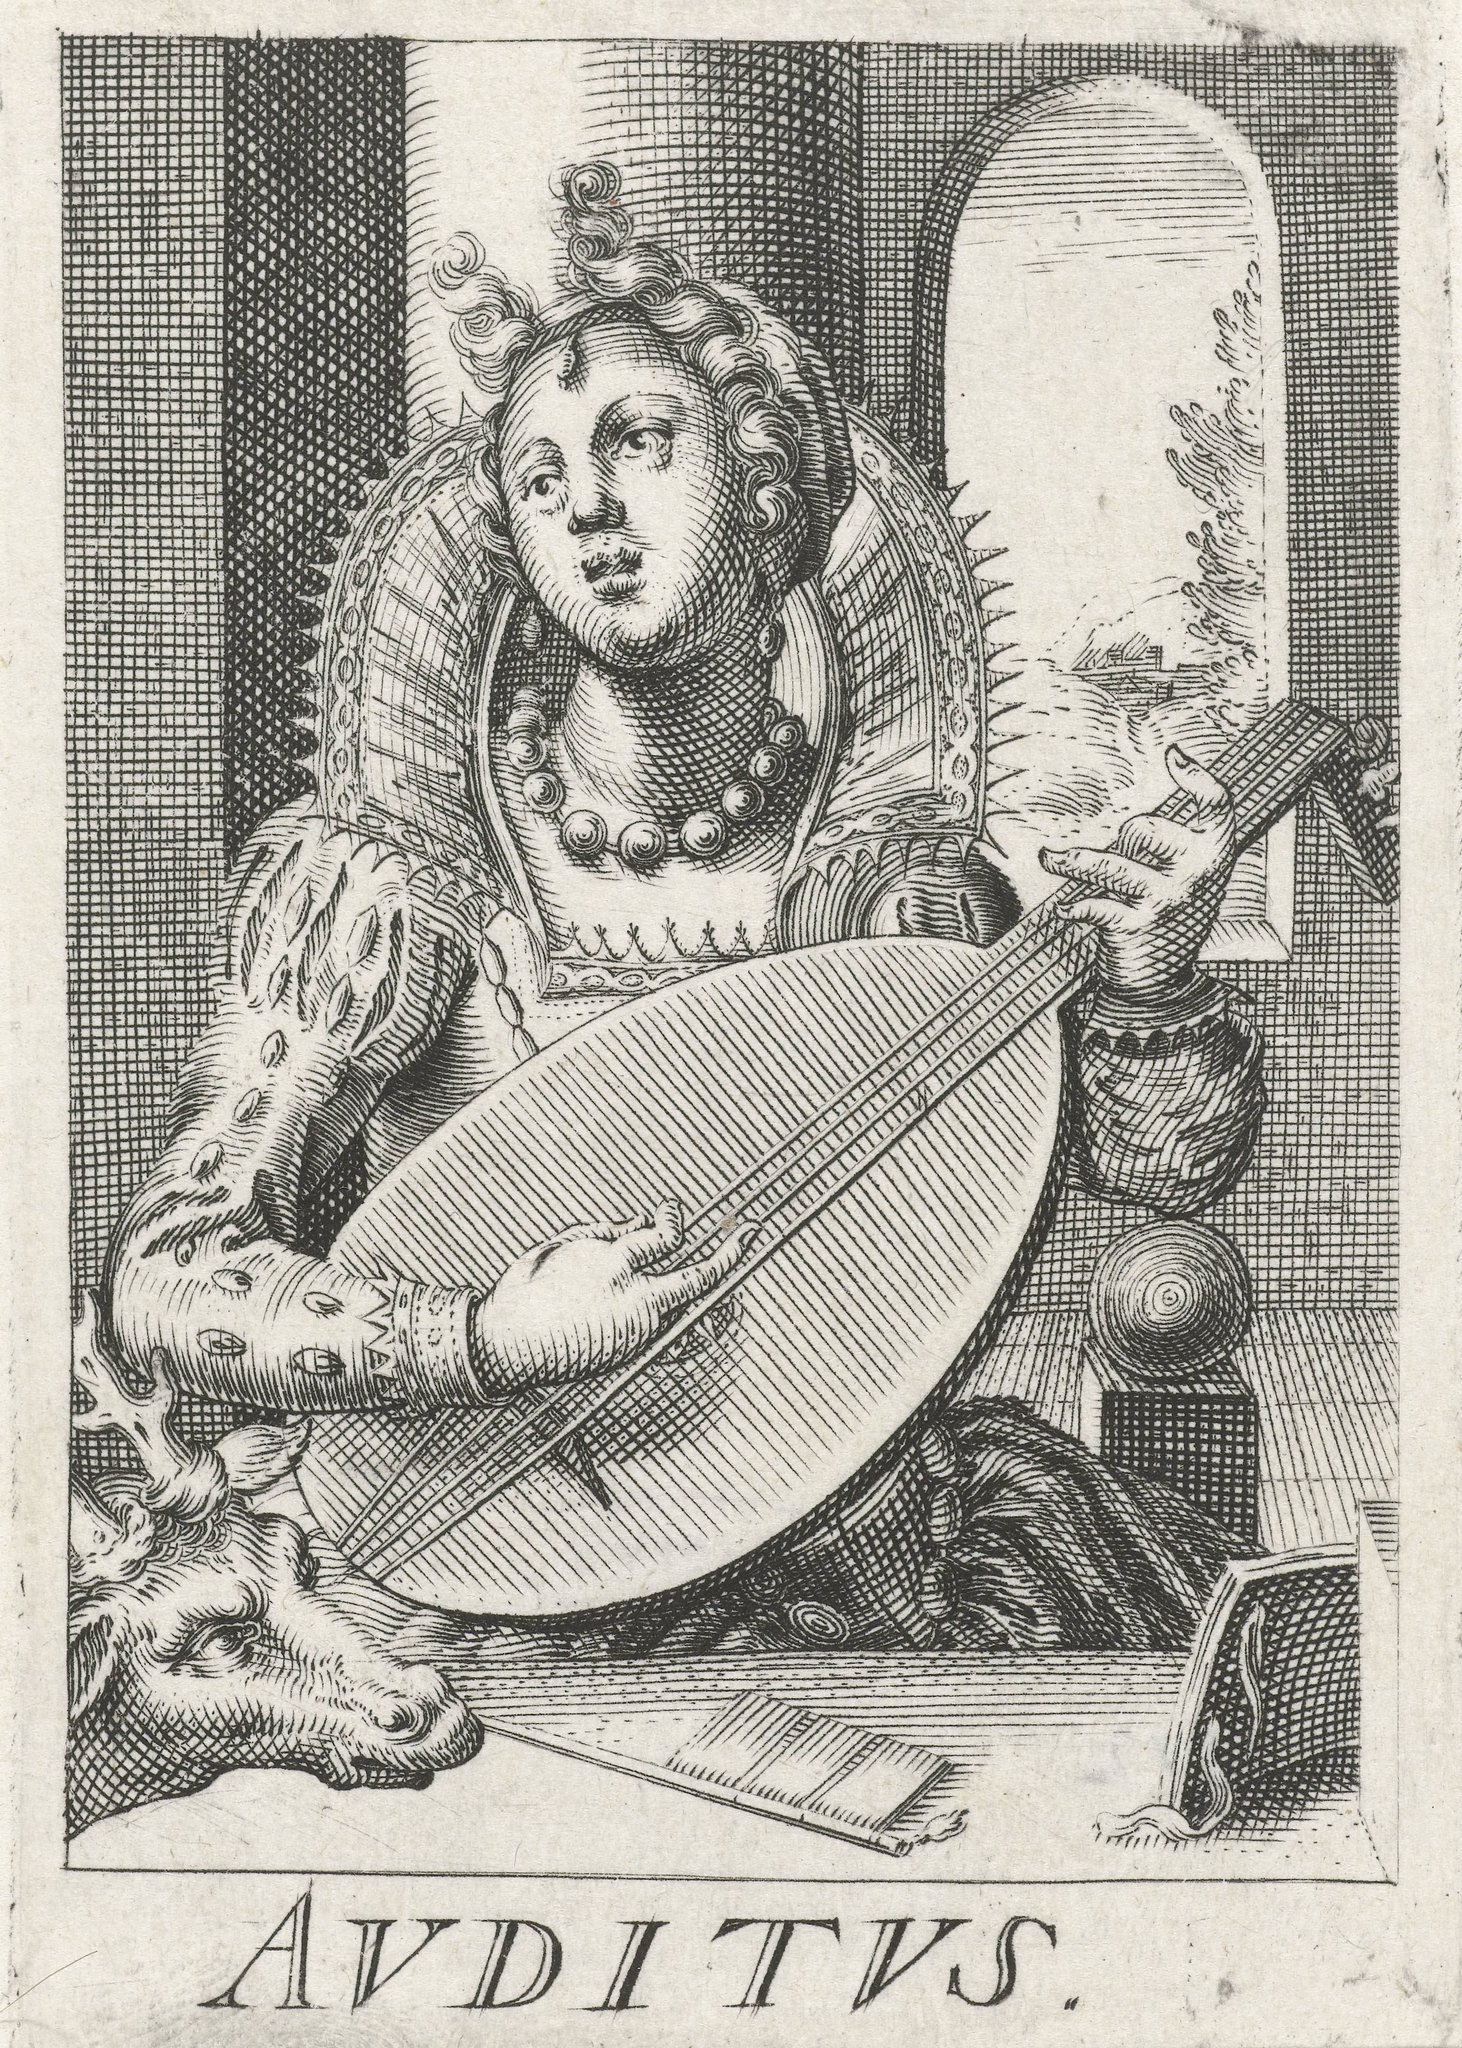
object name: print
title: Auditus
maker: andries jacobsz. stock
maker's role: print maker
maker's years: 1572-1648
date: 1583-1650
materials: paper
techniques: engraving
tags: hearing, listening (one of the five senses)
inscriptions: collector's mark: Lugt 2228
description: Een elegante dame, zittend aan een tafel voor een open raam, bespeelt een snaarinstrument. Linksonder de kop van een hertje. Personificatie van het gehoor, prent uit een serie van de vijf zintuigen.